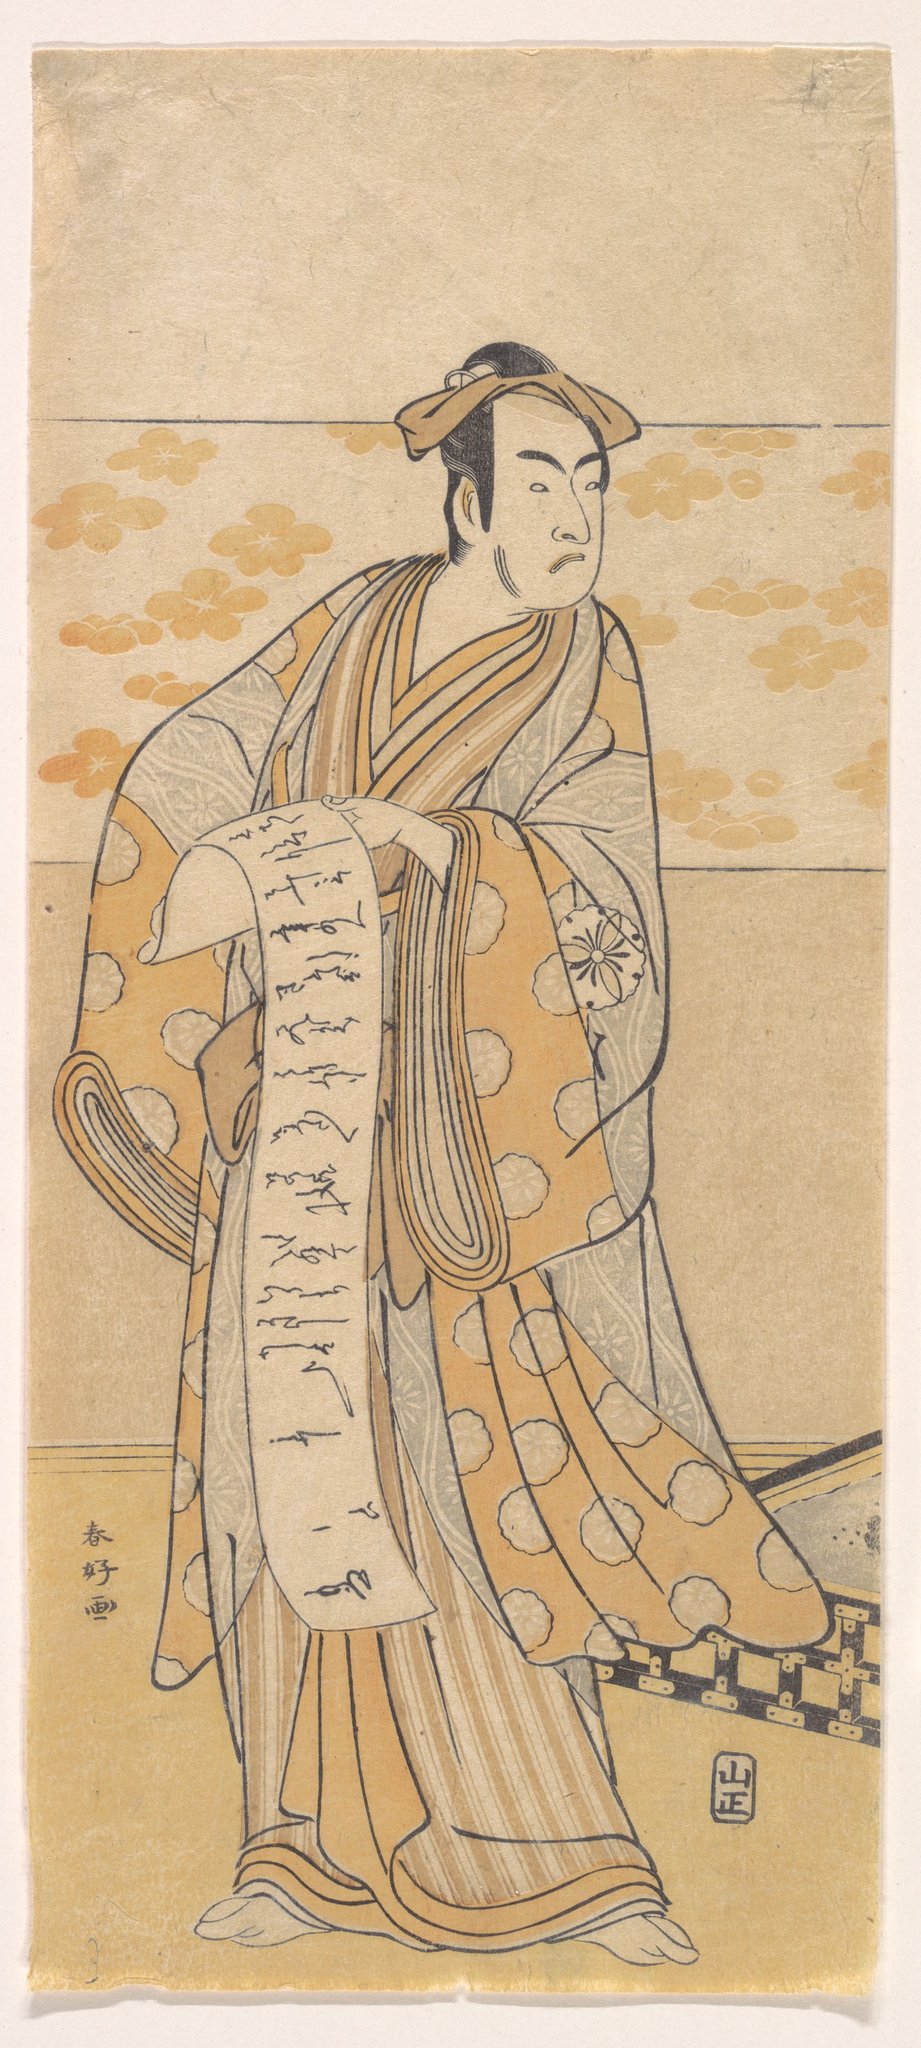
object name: print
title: The Actor, Matsumoto Koshiro I 1674–1730 Reading a Letter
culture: japanese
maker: katsukawa shunkō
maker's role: artist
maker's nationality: japanese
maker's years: 1743-1812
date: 1743-1812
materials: ink, paper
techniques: woodblock print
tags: men,reading,actors